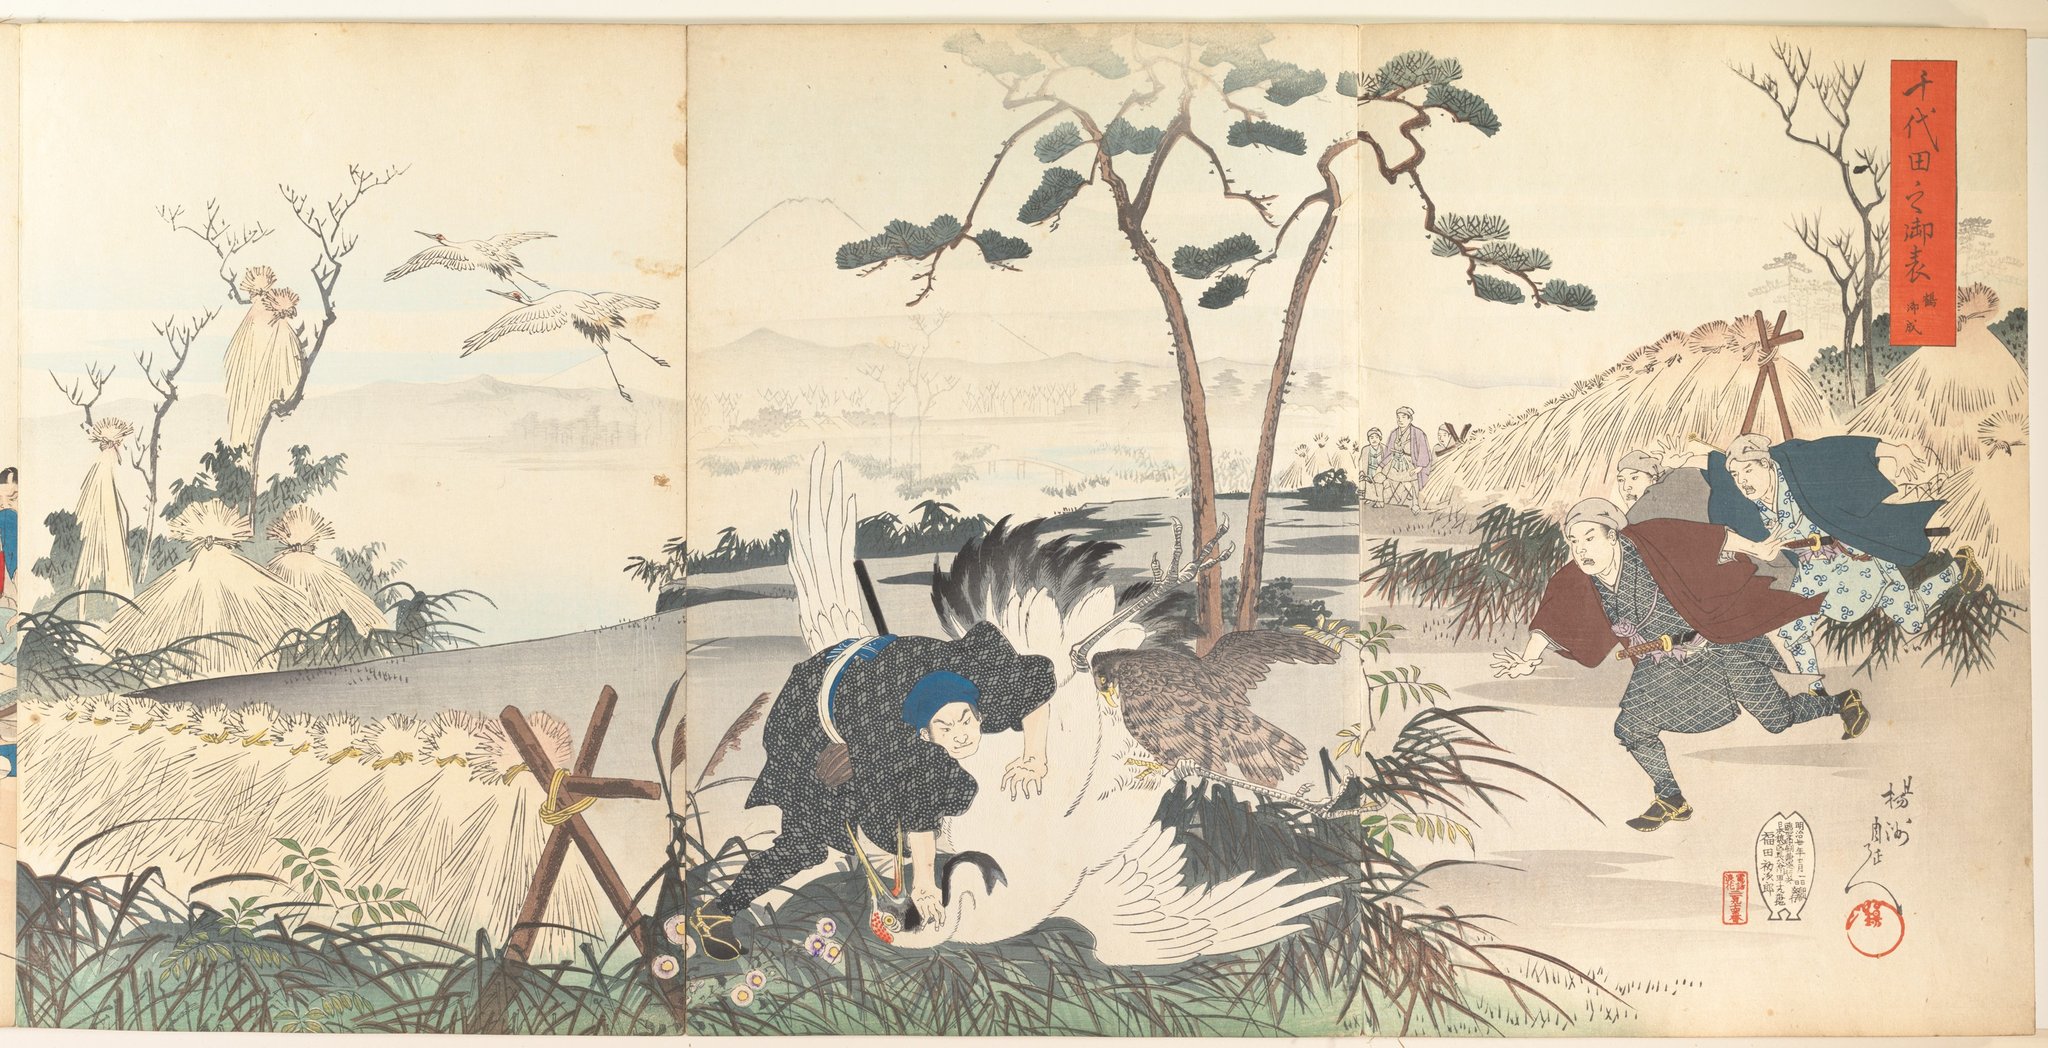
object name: print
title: Chiyoda Castle (Album of Men)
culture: japanese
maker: yōshū (hashimoto) chikanobu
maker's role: artist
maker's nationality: japanese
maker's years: 1838-1912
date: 1897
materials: ink, paper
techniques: woodblock print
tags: birds,men,landscapes,trees